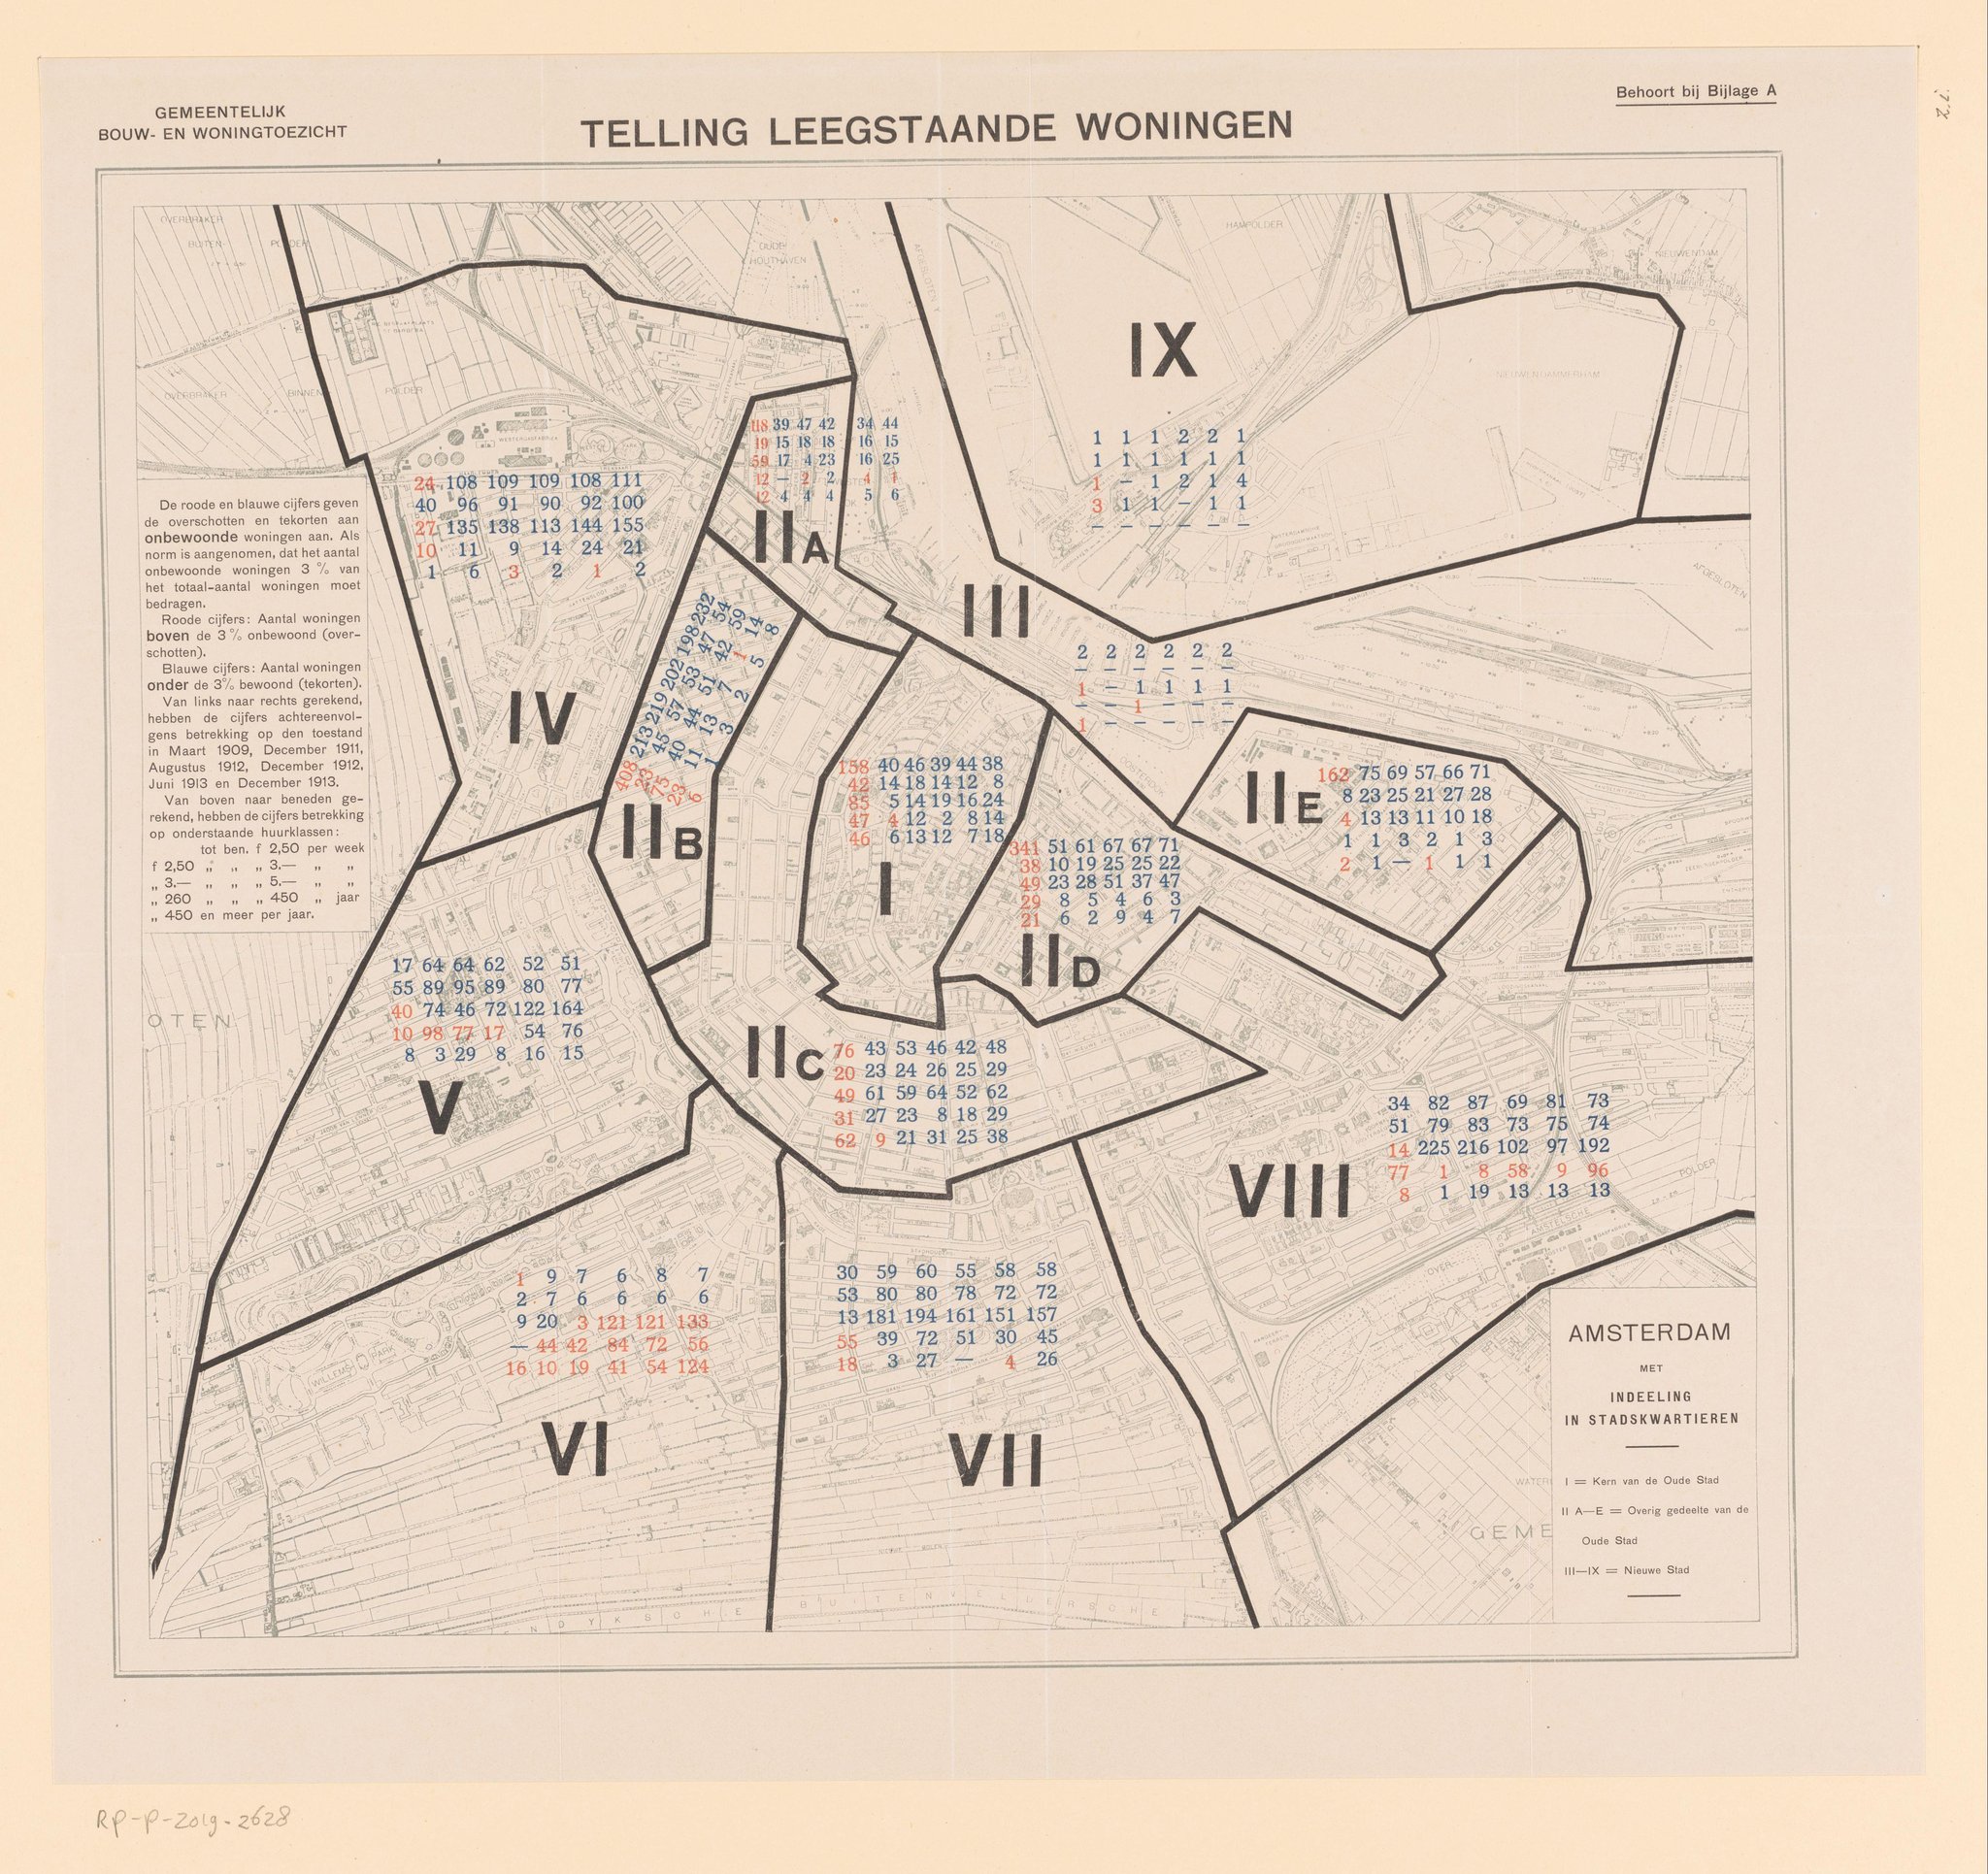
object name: reproduction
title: Amsterdam met indeeling in stadskwartieren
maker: Anonymous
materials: paper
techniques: photolithography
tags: maps of cities, amsterdam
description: Bovenin: Gemeentelijke Bouw- en Woningtoezicht. Behoort bij Bijlage A.